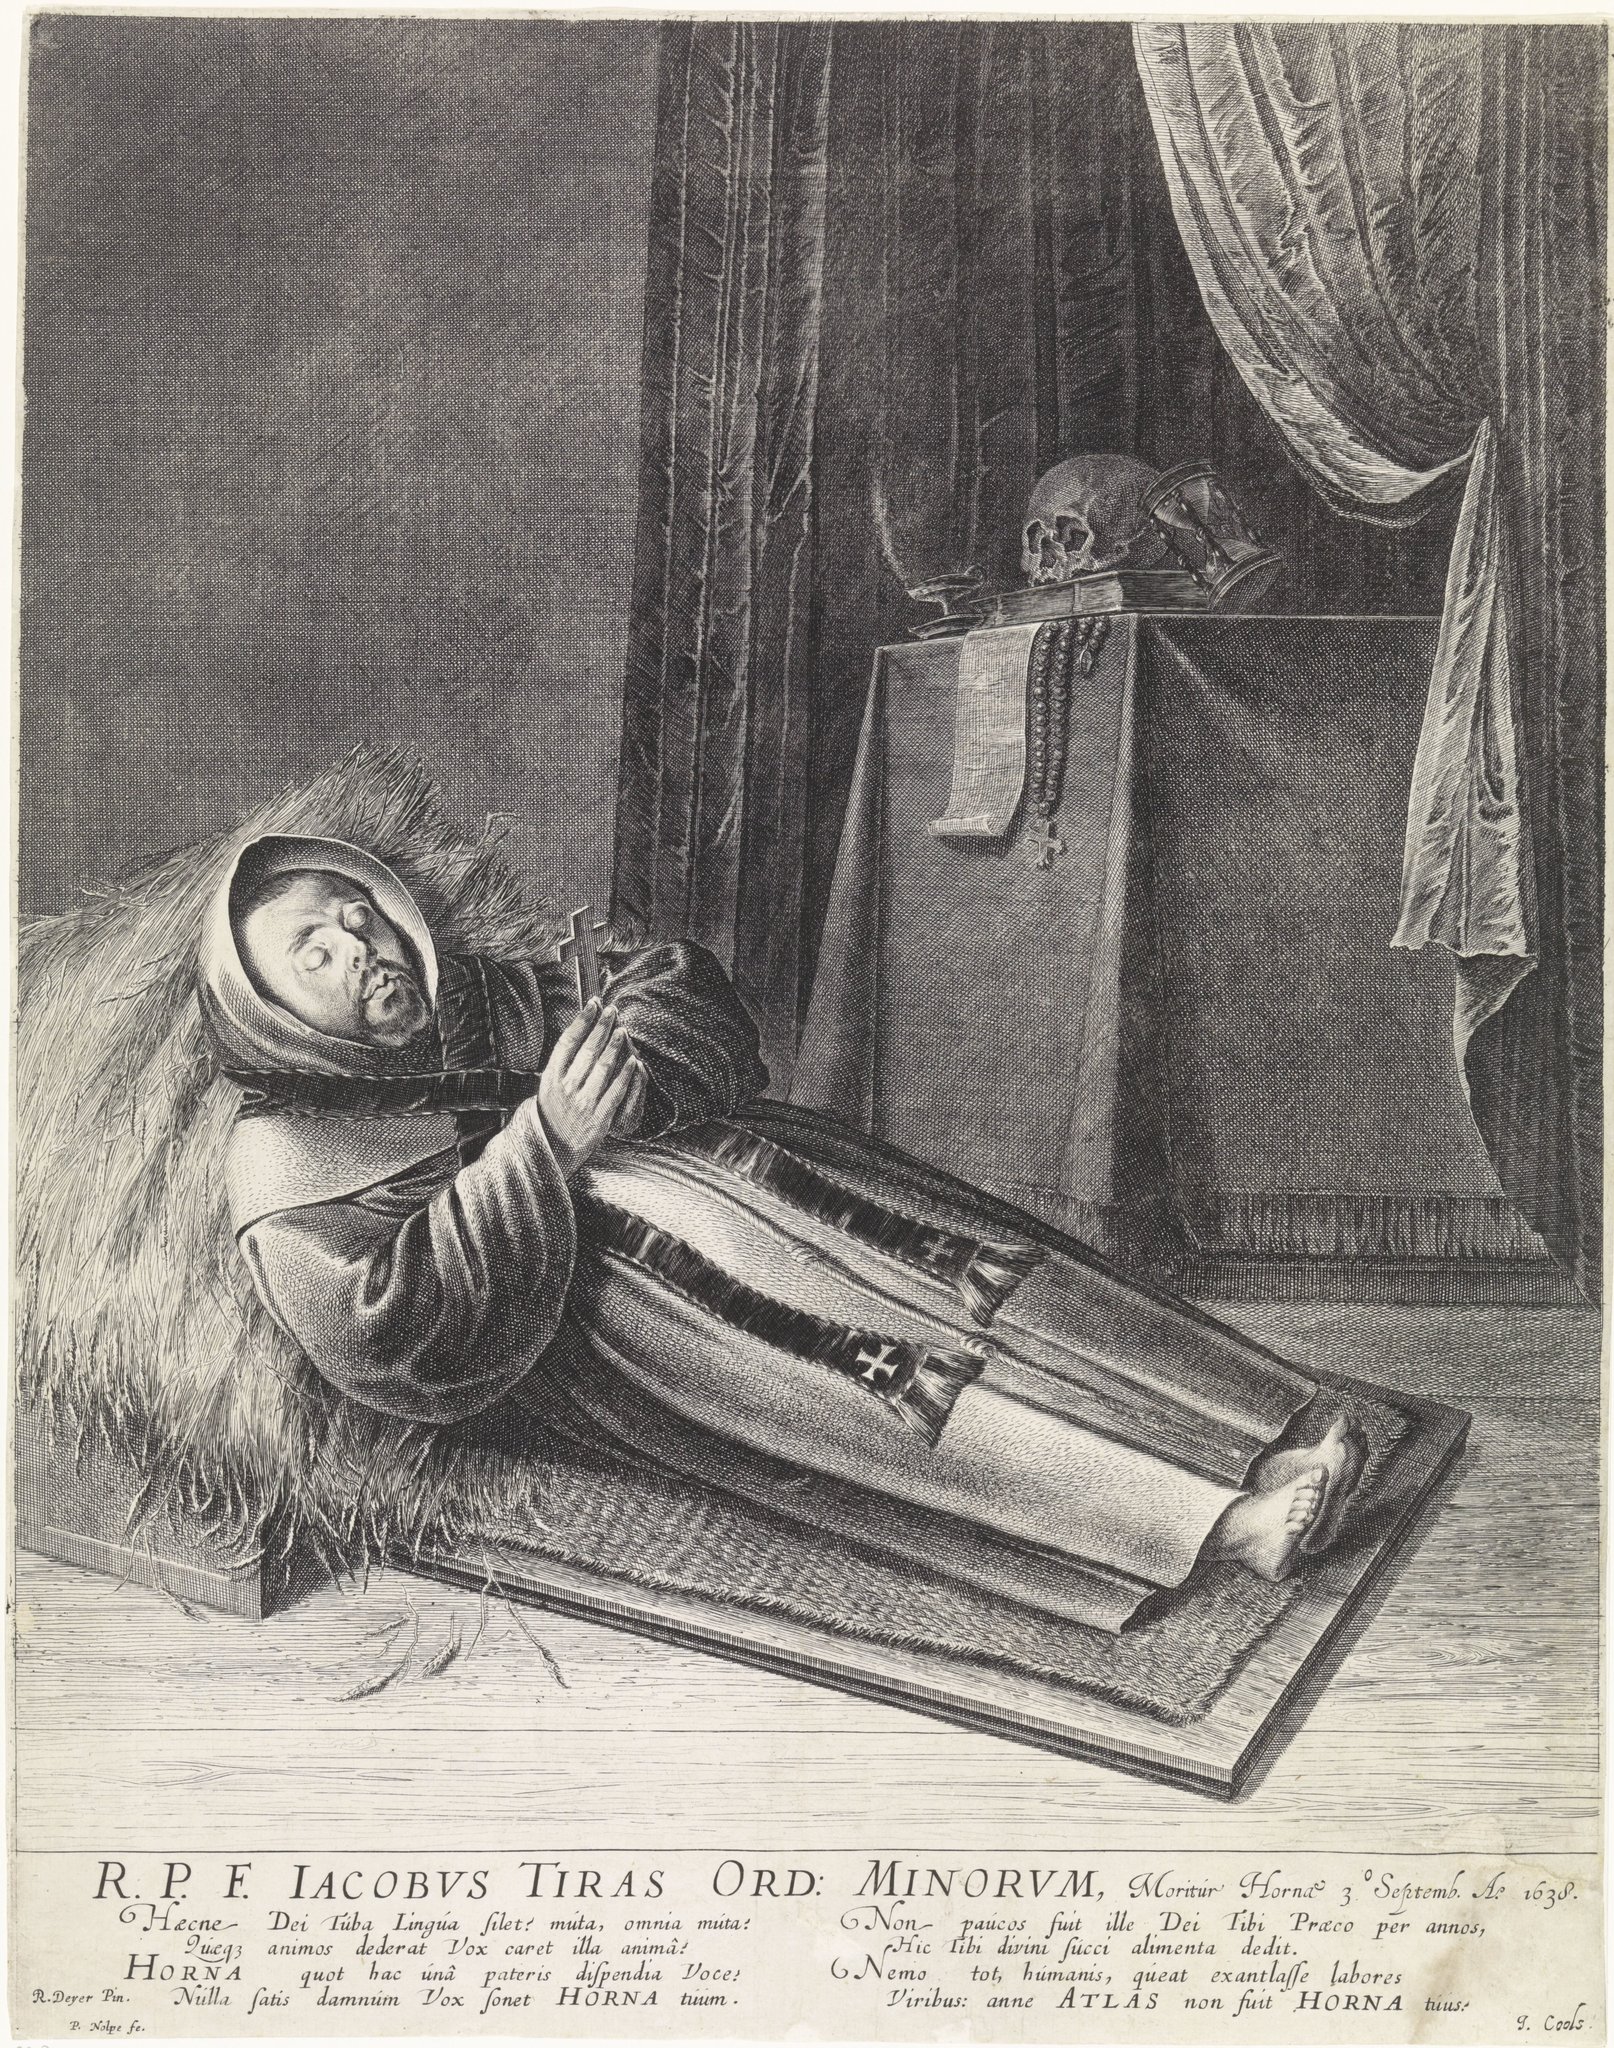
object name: print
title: Jacobus Tyras, opgebaard op een bed van stro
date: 1638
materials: paper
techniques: engraving, etching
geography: amsterdam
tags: deathbed, monk(s), friar(s), hourglass, death's head, skull (symbol of death)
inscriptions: collector's mark: Lugt 240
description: De gestorven minderbroeder Jacobus Tyras ligt opgebaard op een mat en een bundel stro met een kruis in zijn handen. Op de tafel liggen een gebedssnoer en boek. Een uitdovende lamp, schedel en zandloper duiden op het voorbij gaan van de tijd en op de dood. Onderaan twee kolommen met een vierregelige tekst in het Latijn.